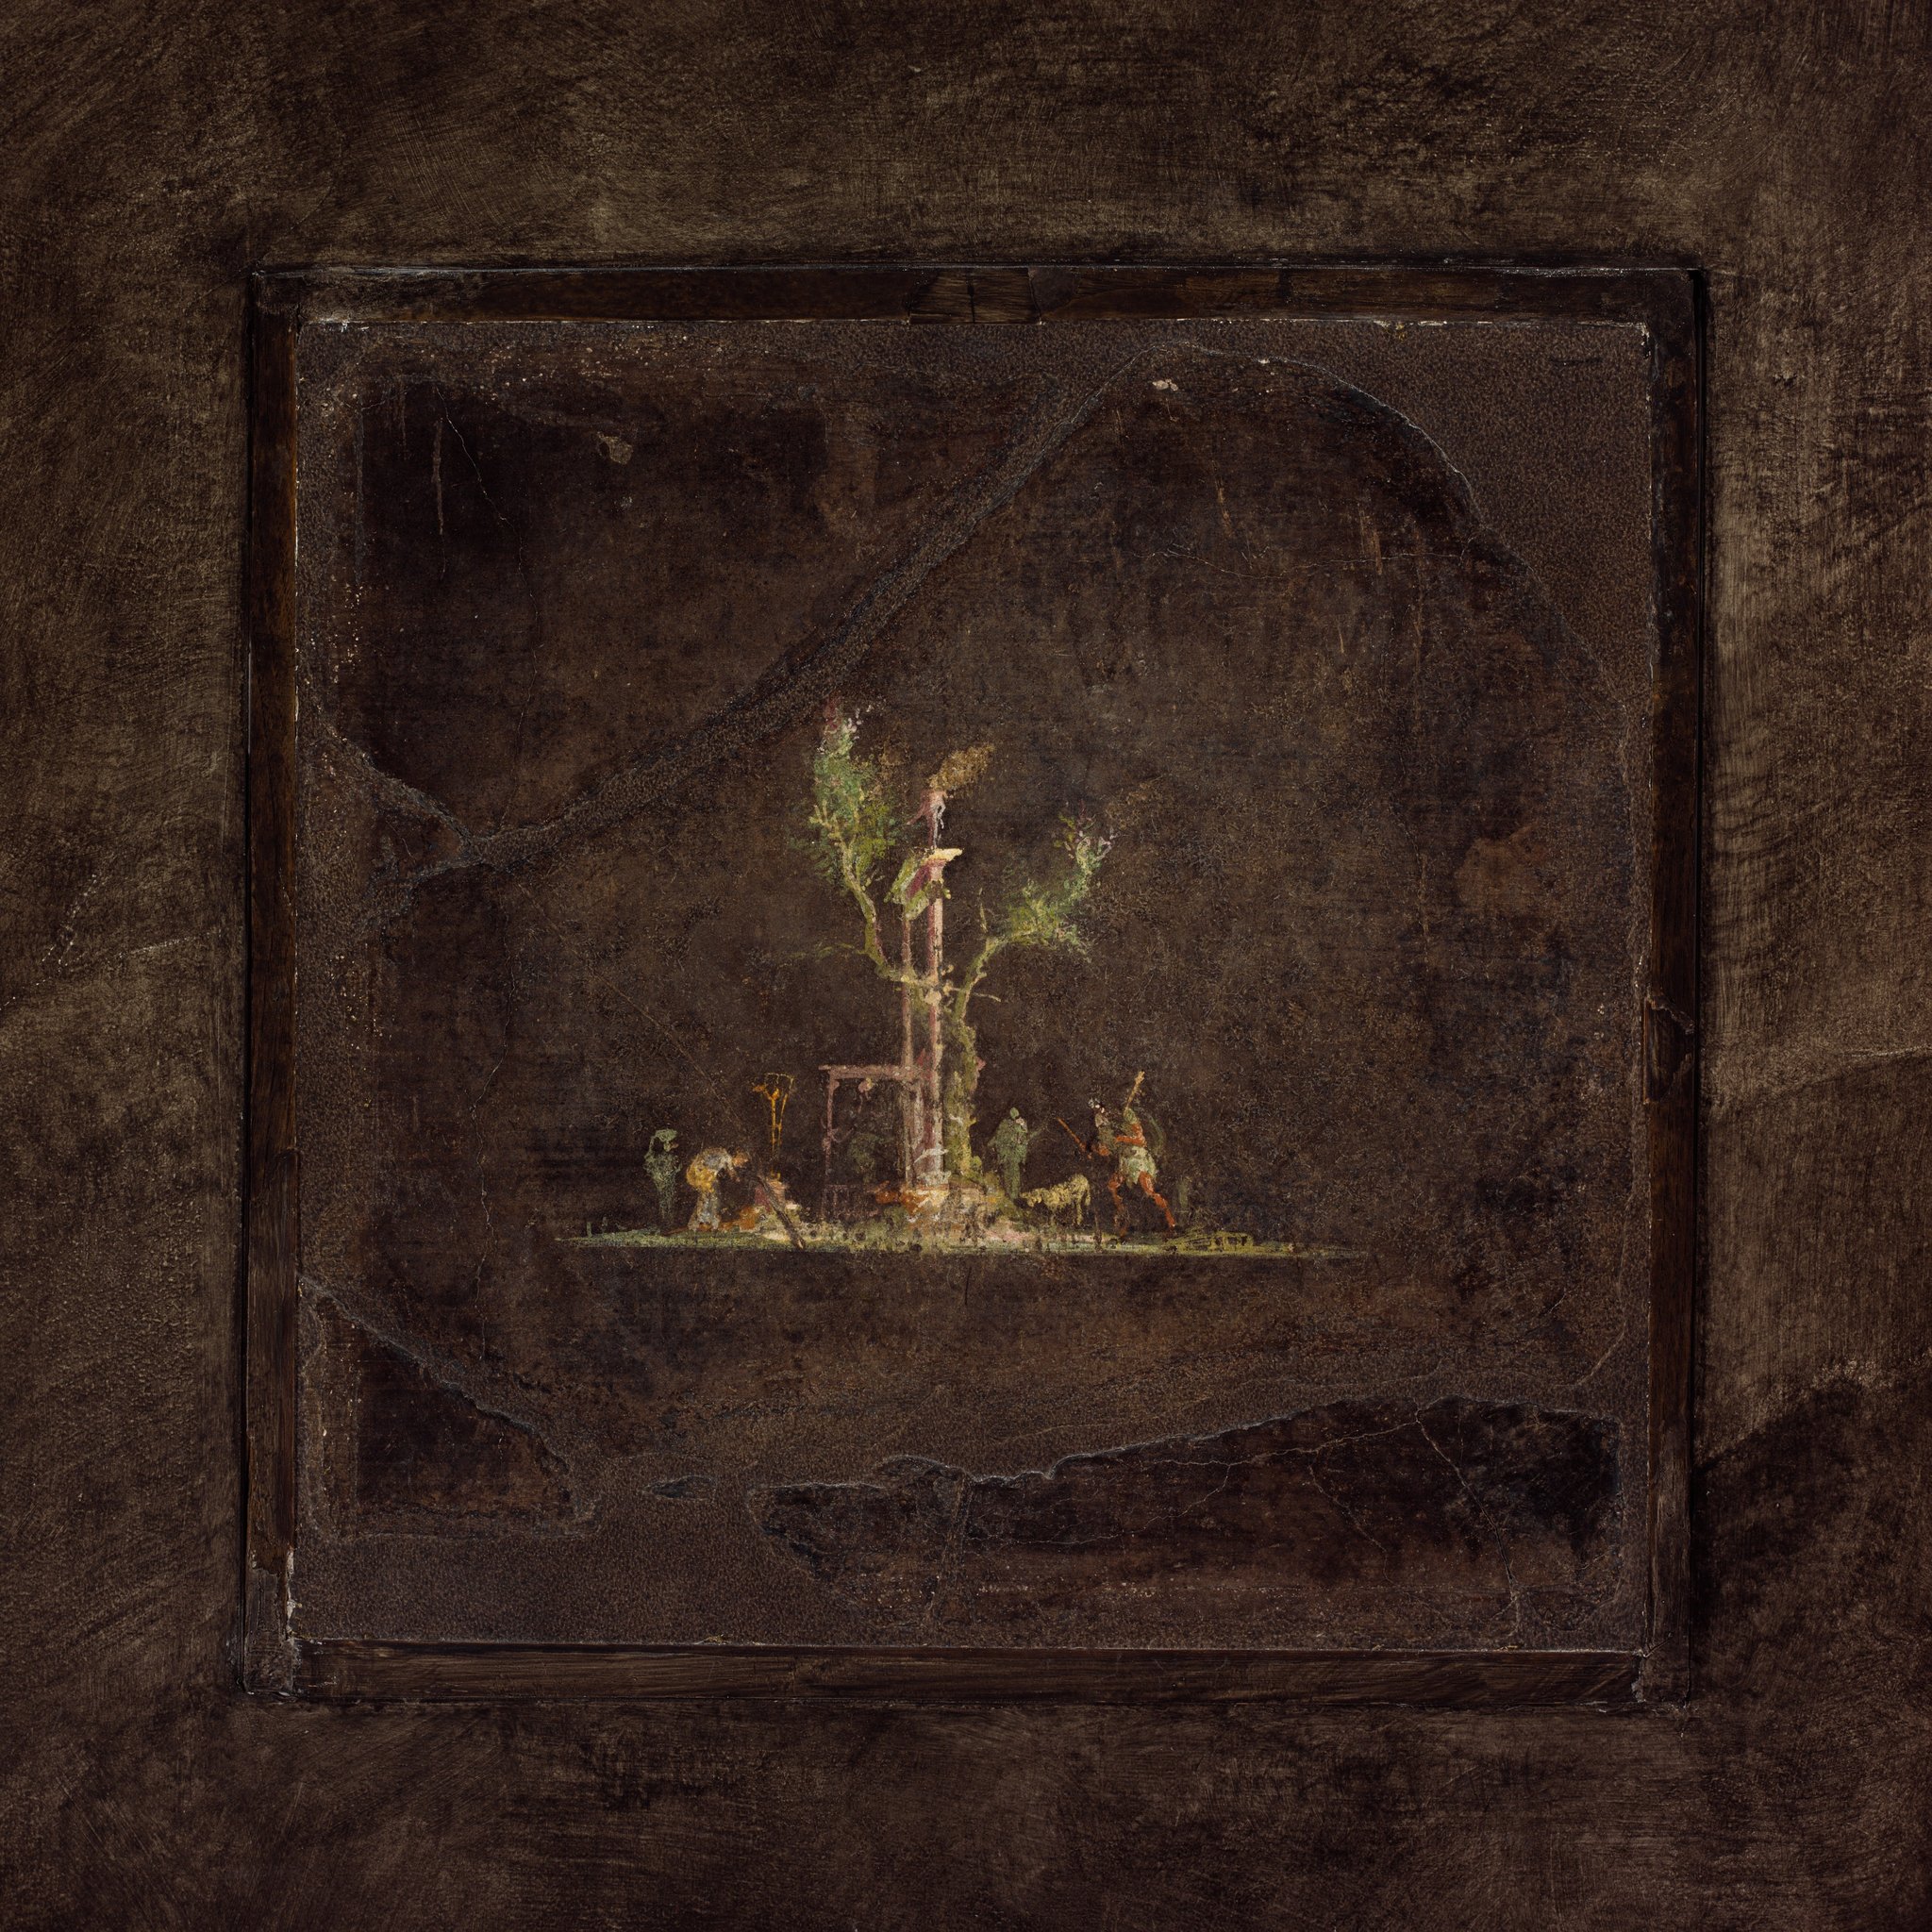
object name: wall painting on black ground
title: Wall painting on black ground: landscape, from the imperial villa at Boscotrecase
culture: roman, pompeian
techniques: fresco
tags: human figures,trees